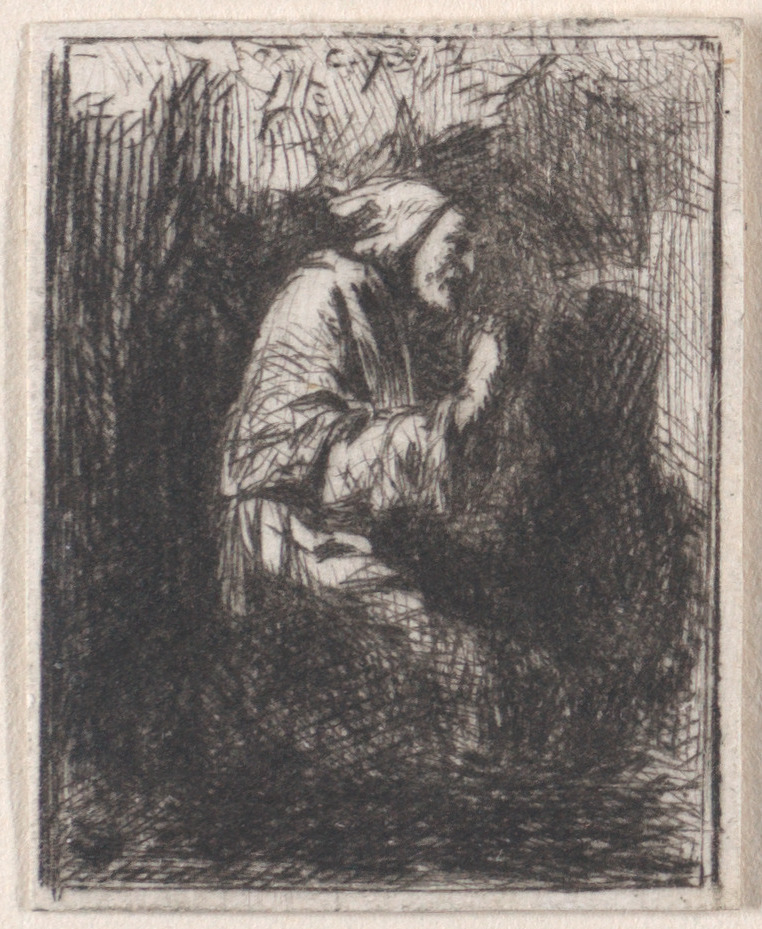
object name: print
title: Praying Monk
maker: charles émile jacque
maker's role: artist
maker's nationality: french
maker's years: 1813-1894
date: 1843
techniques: drypoint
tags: men,monks,praying